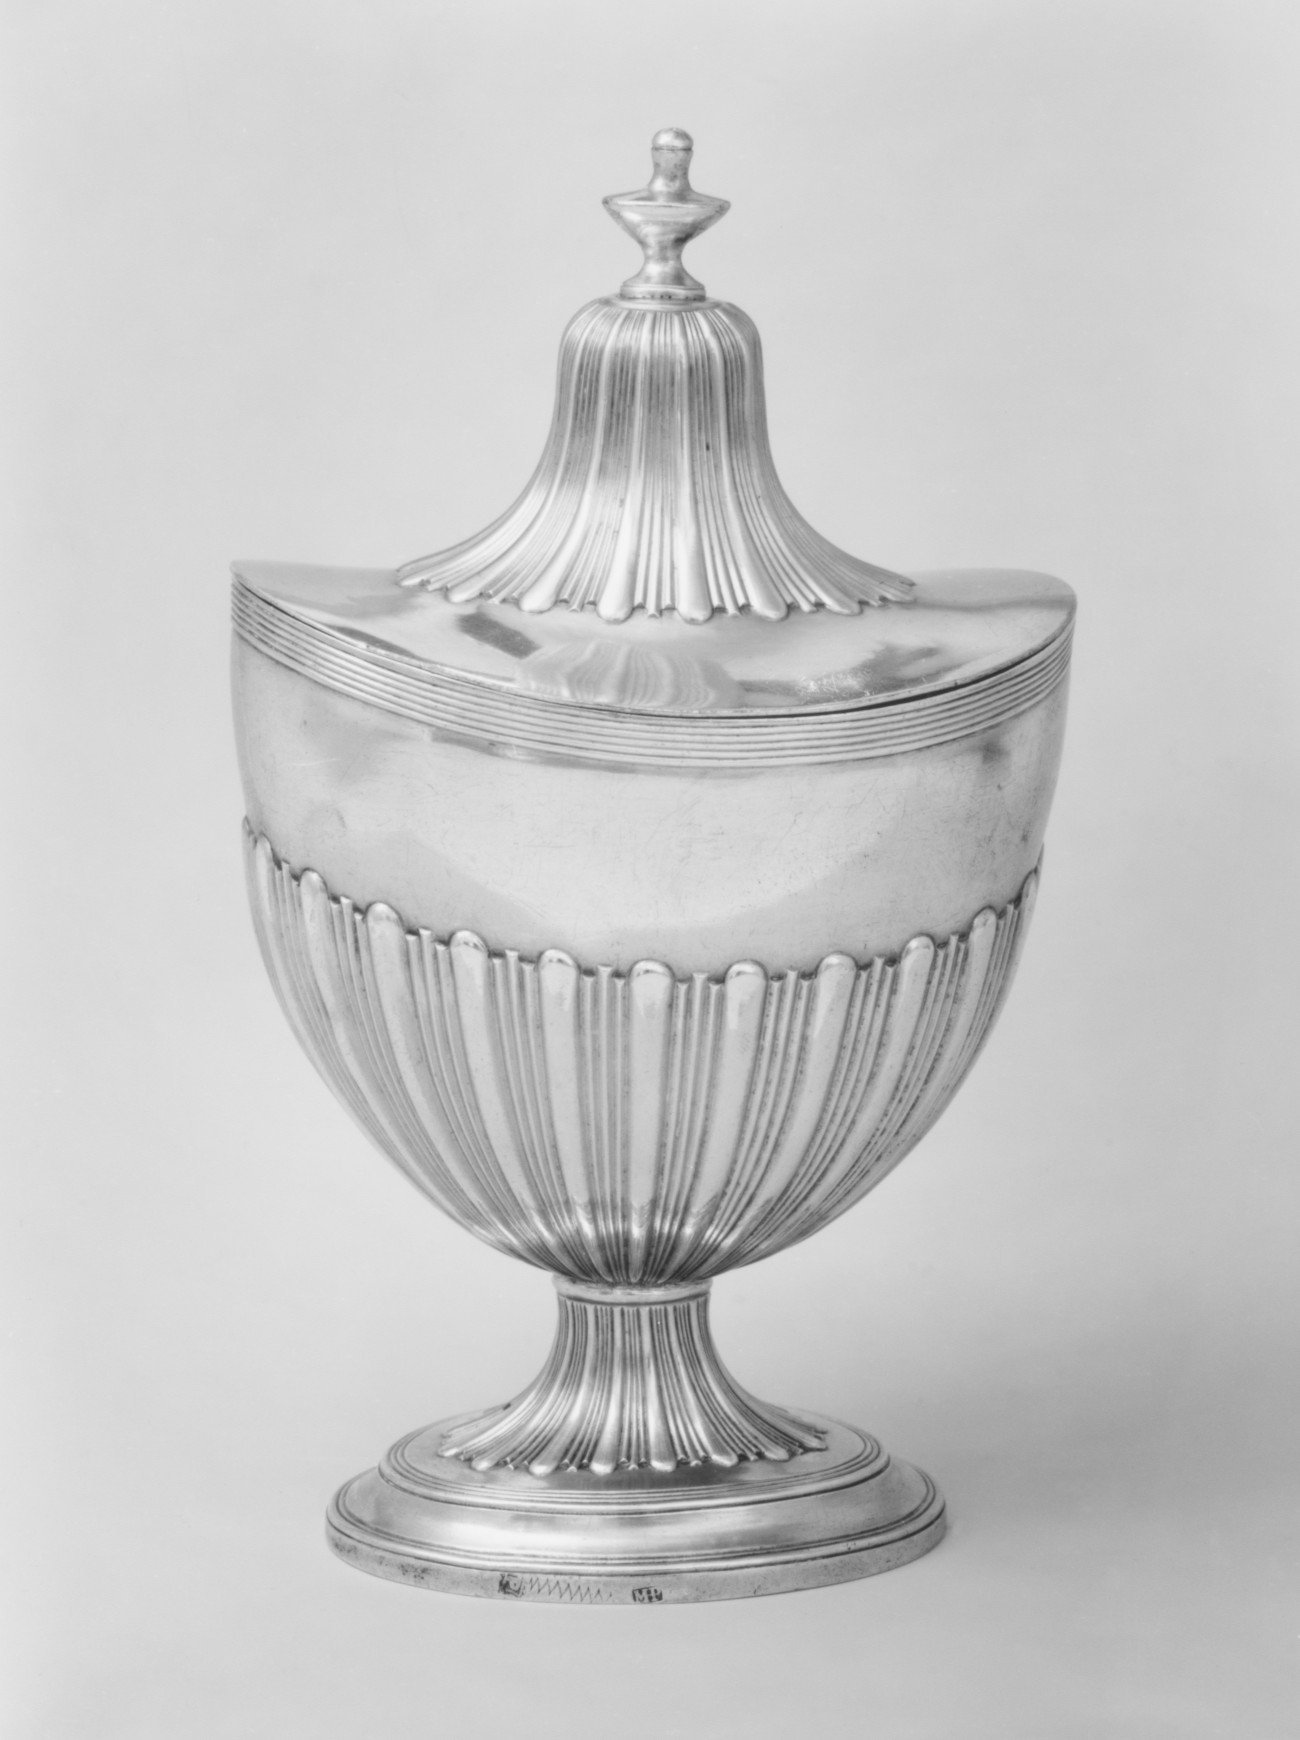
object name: sugar bowl with cover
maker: m. h. p.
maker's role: maker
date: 1776-1800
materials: silver